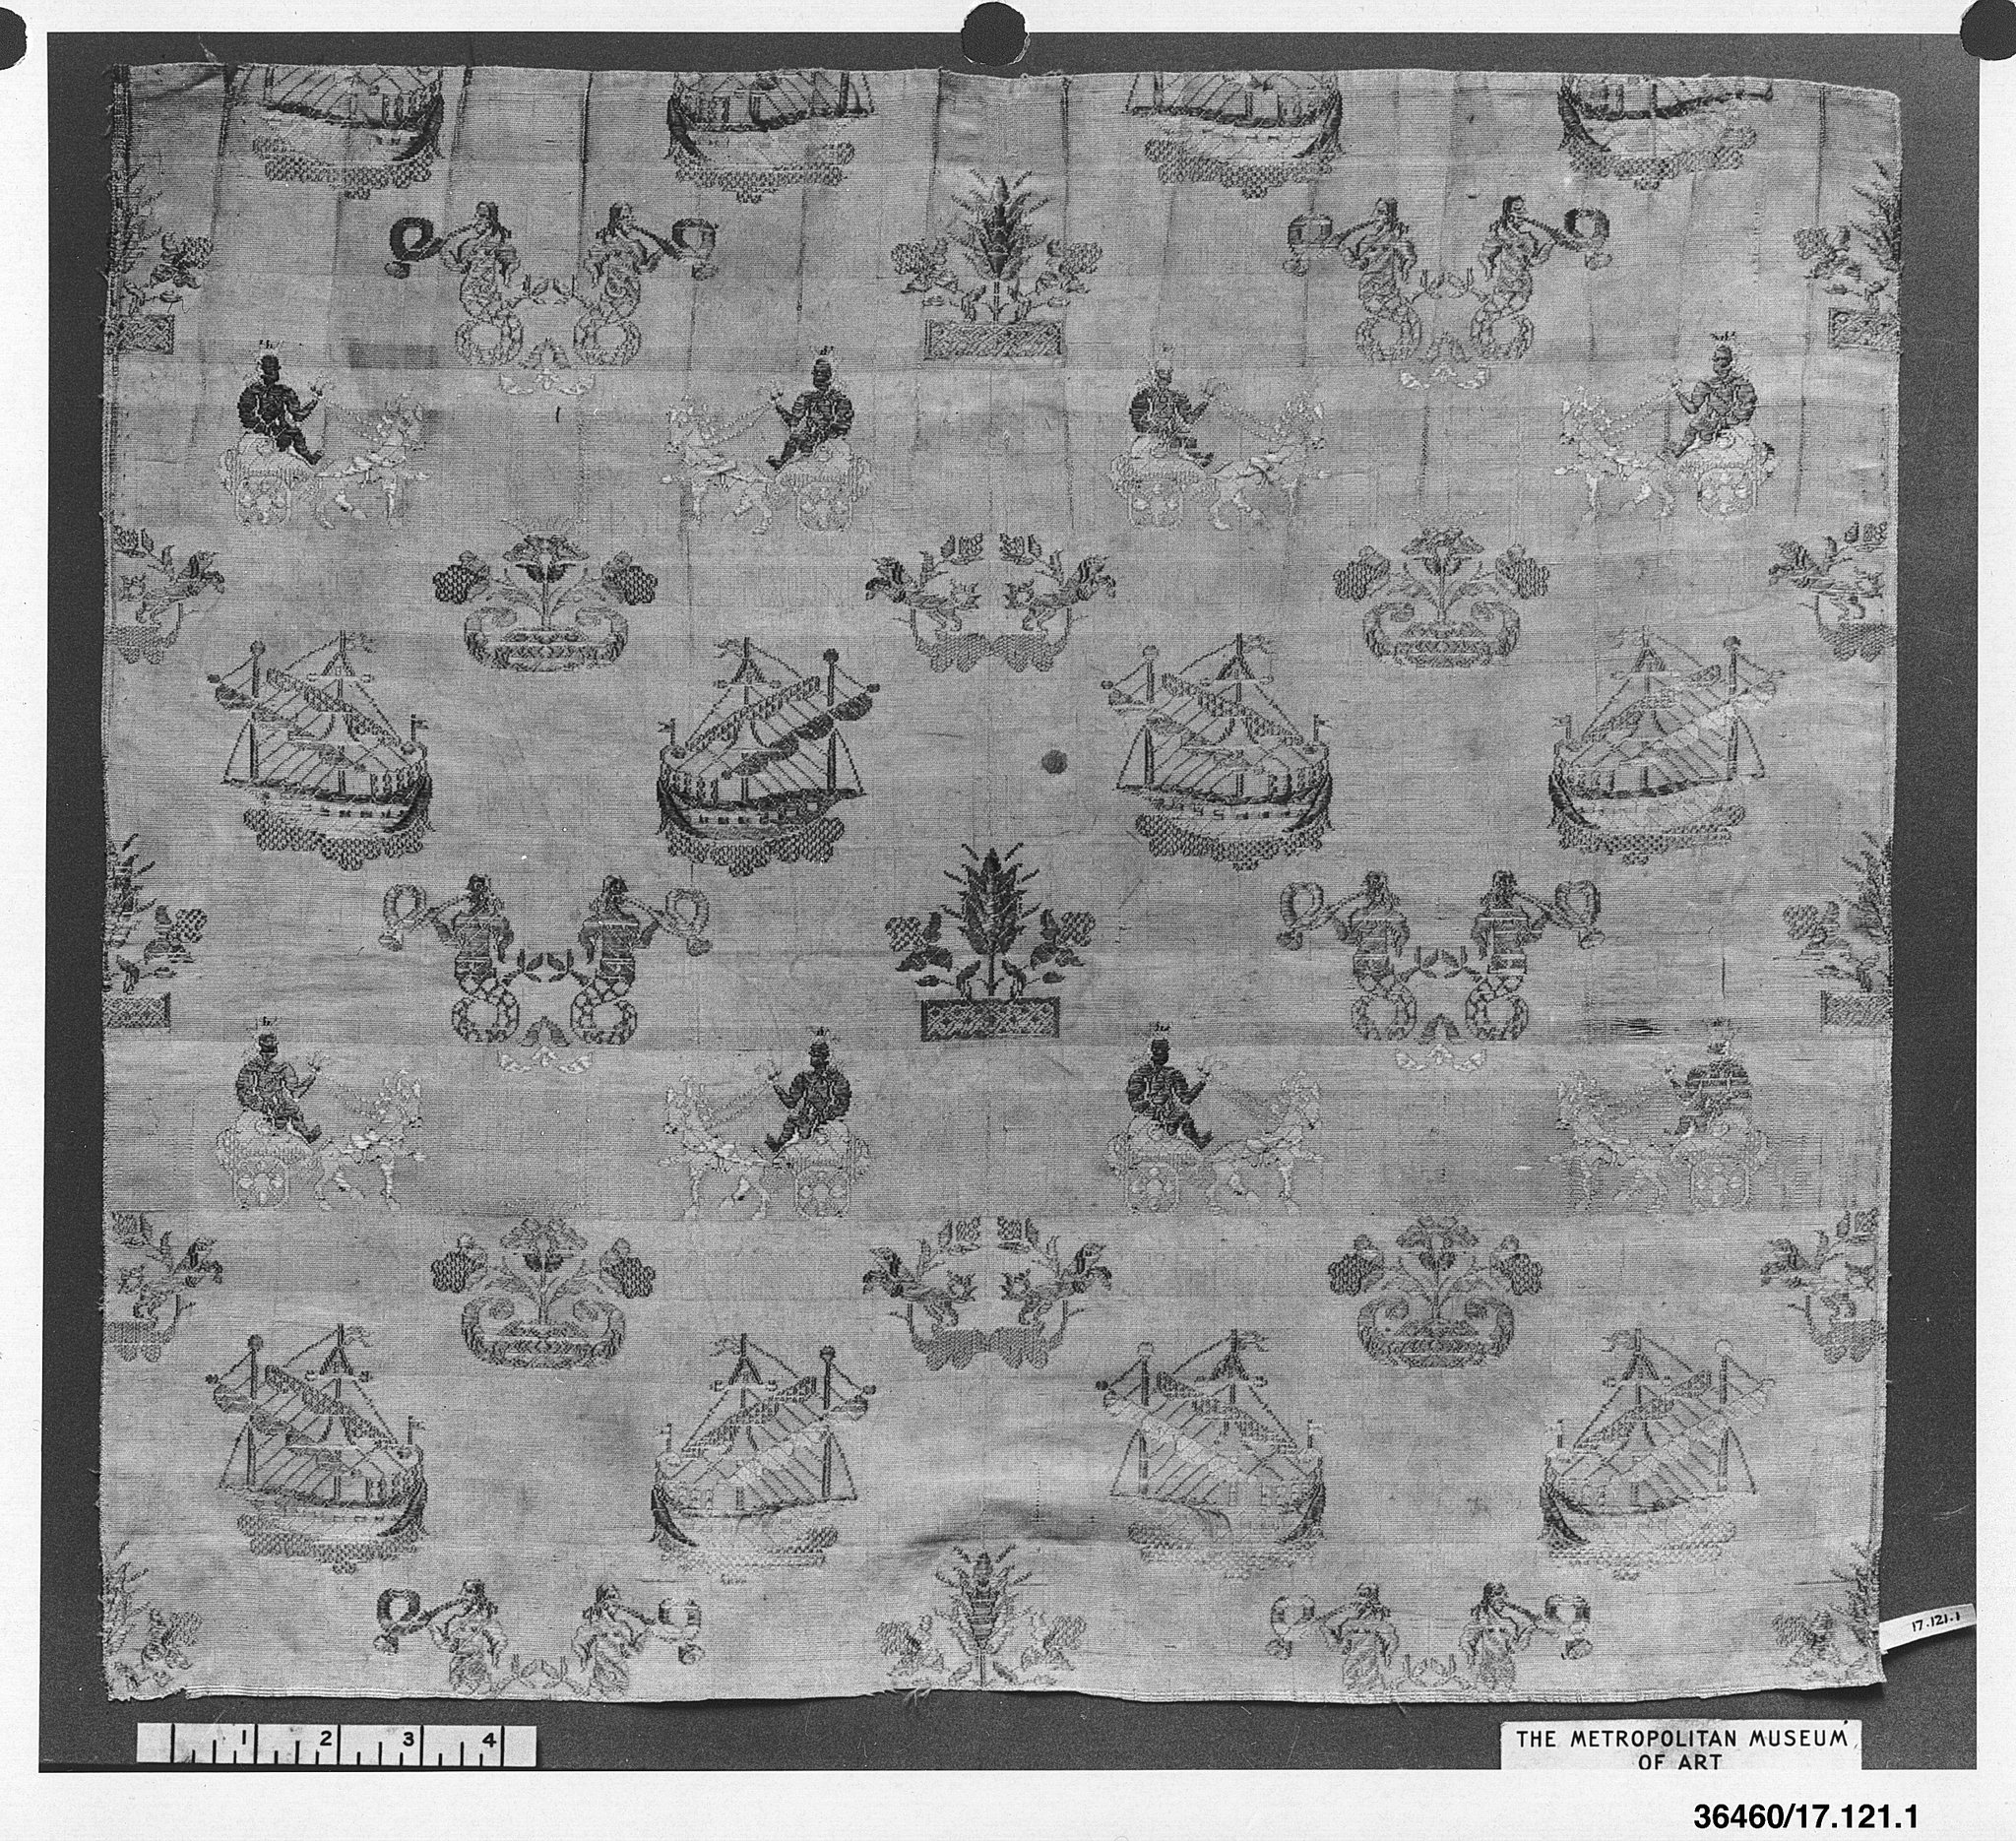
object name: fragment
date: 1601-1700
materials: silk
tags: mermaids,flowers,carriages,ships